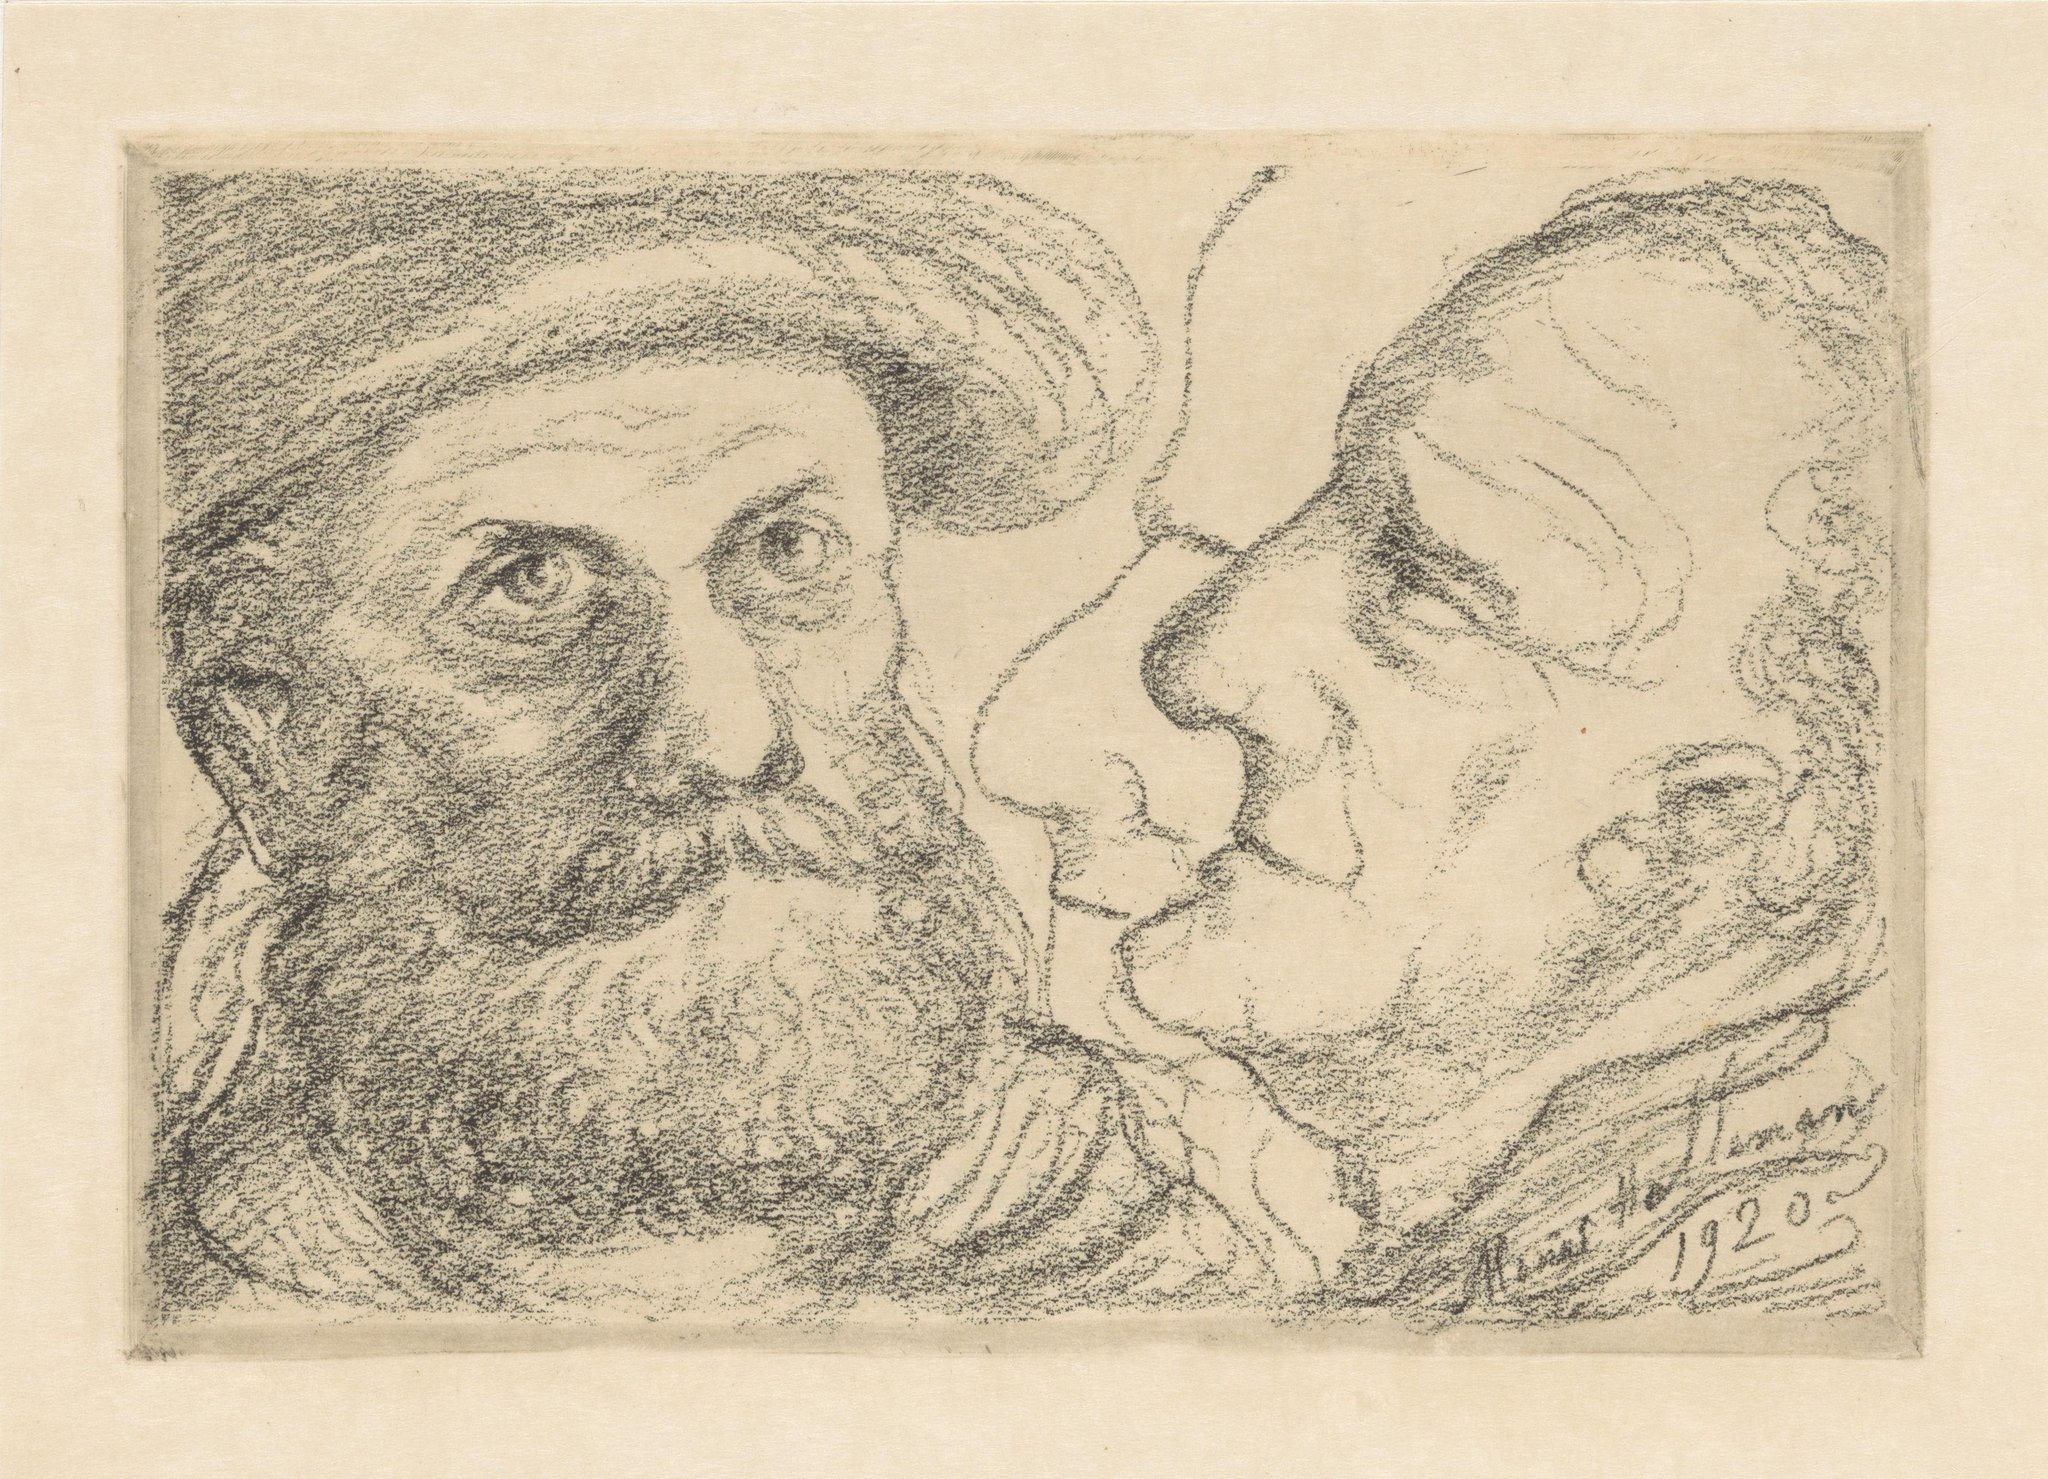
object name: print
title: Man met baard en hoed en kalende man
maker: marius holleman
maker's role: draughtsman, print maker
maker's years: 1878-1926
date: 1920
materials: paper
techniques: etching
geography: groningen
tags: head-gear: hat, beard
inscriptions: collector's mark: Lugt 2228